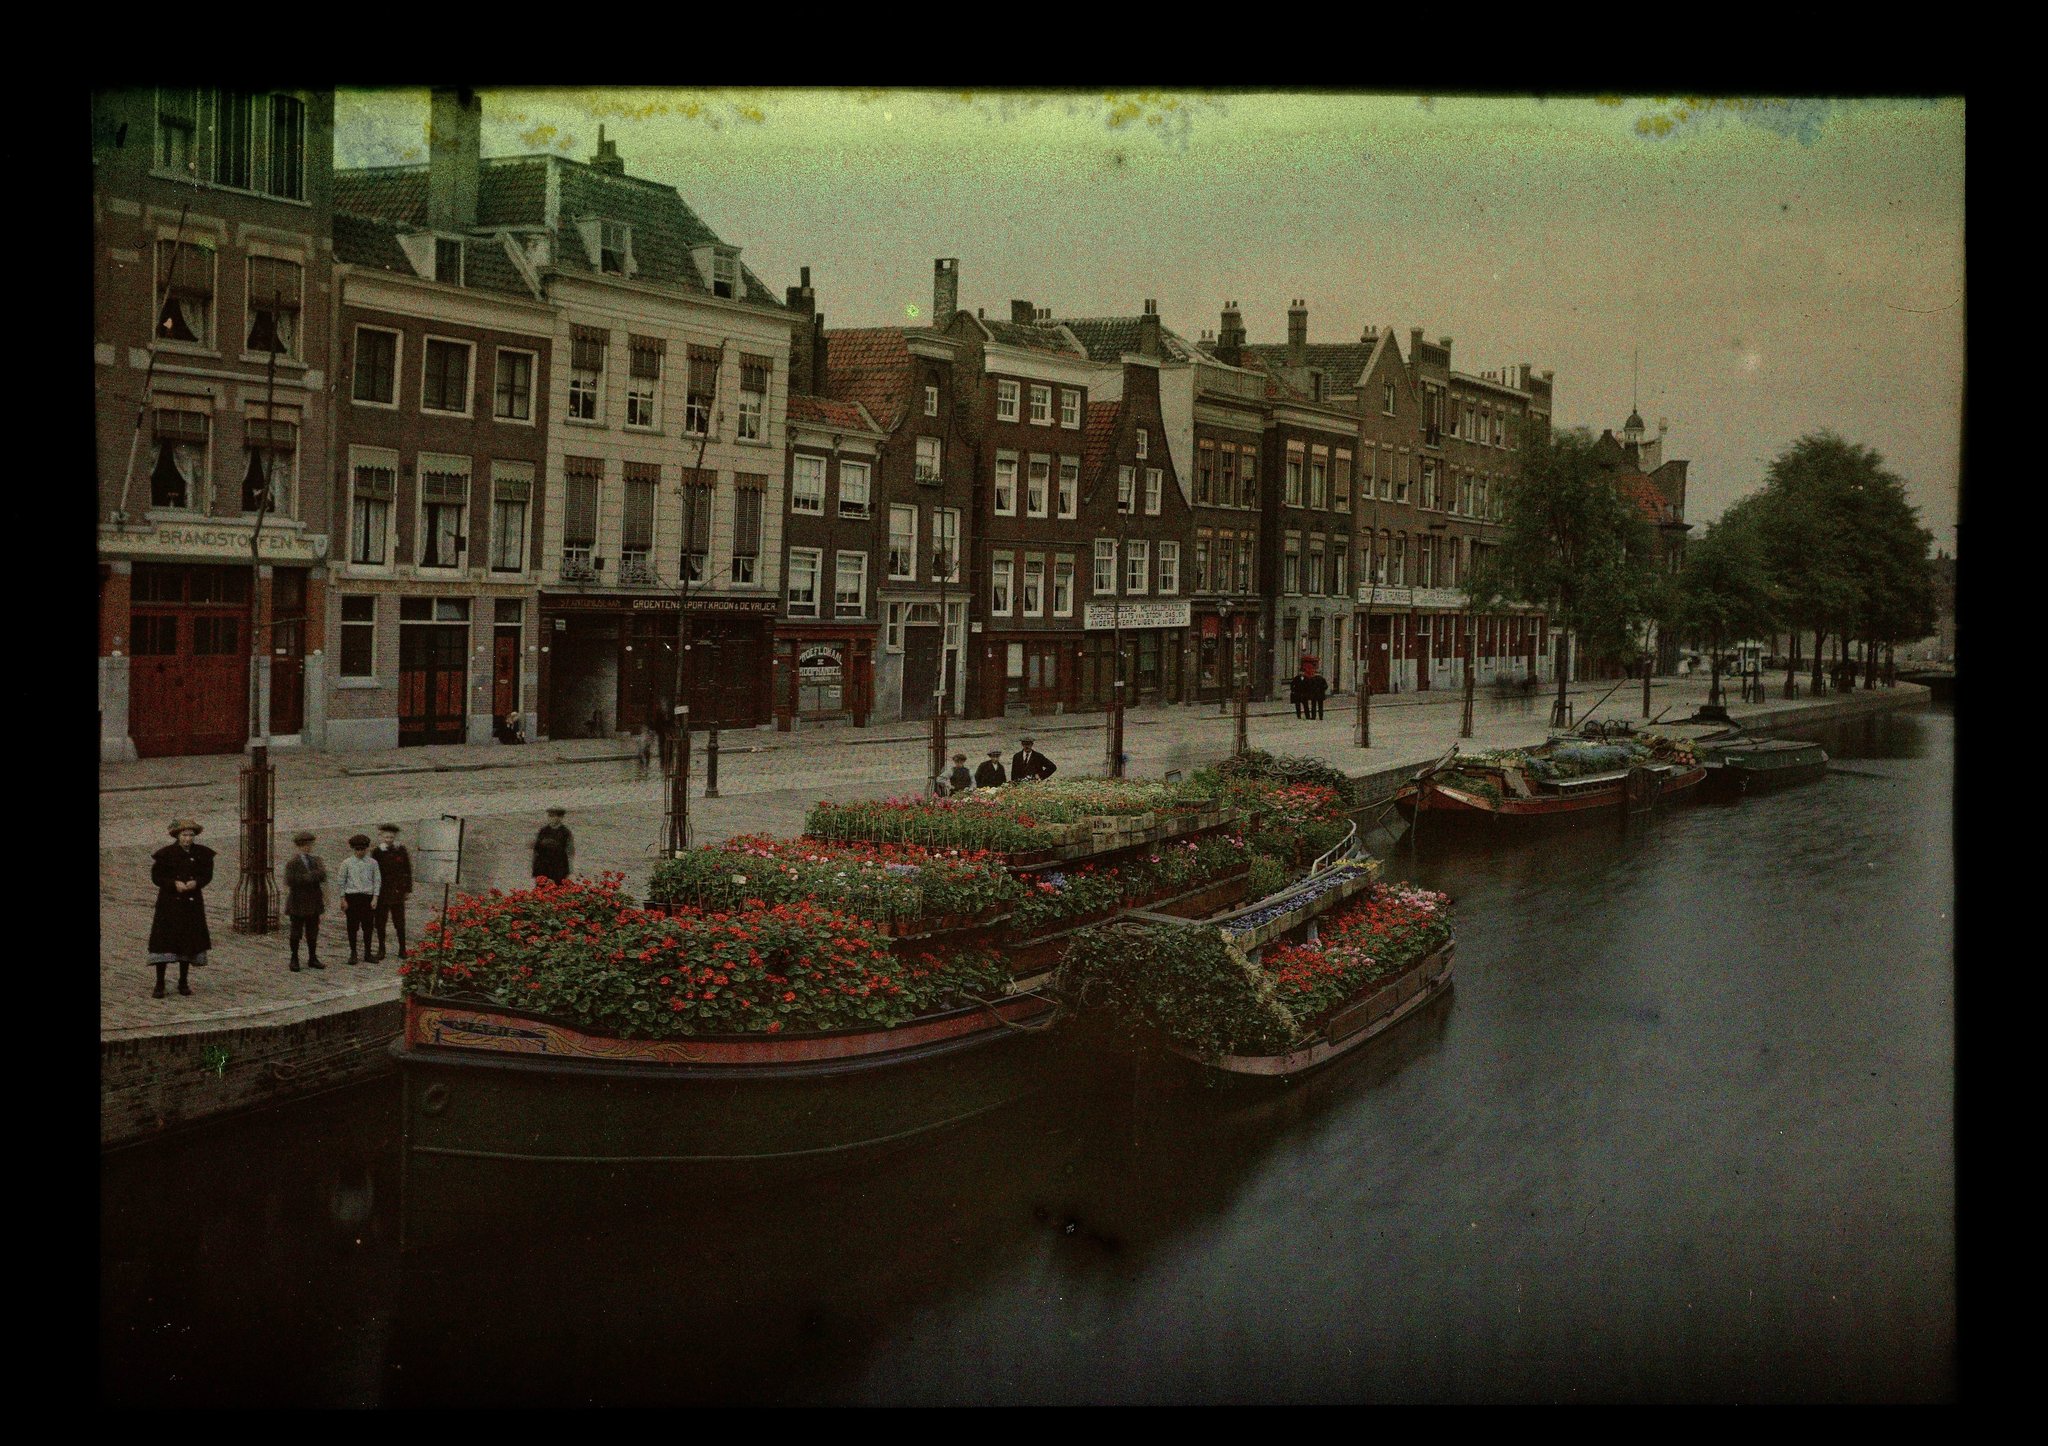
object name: photograph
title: Schuiten met bloemen afgemeerd aan de Rechter Rottekade, Rotterdam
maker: sebastiaan alphonse van besten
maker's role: painter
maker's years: 1864-1926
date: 1915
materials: glass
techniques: autochrome process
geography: rotterdam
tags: flowers, quay, rotterdam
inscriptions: annotation: ‘Rotterdam 1915’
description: Links de brandstoffenhandel van A. Heus (nr. 135), iets verderop de groentenexporthandel van Kroon & De Vrijer (nr. 129a). Identificatie gracht gebaseerd op de op de foto leesbare naam Kroon & De Vrijer en het adresboek van Rotterdam 1915, dat voor deze firma het adres Rechter Rottekade 129a geeft.